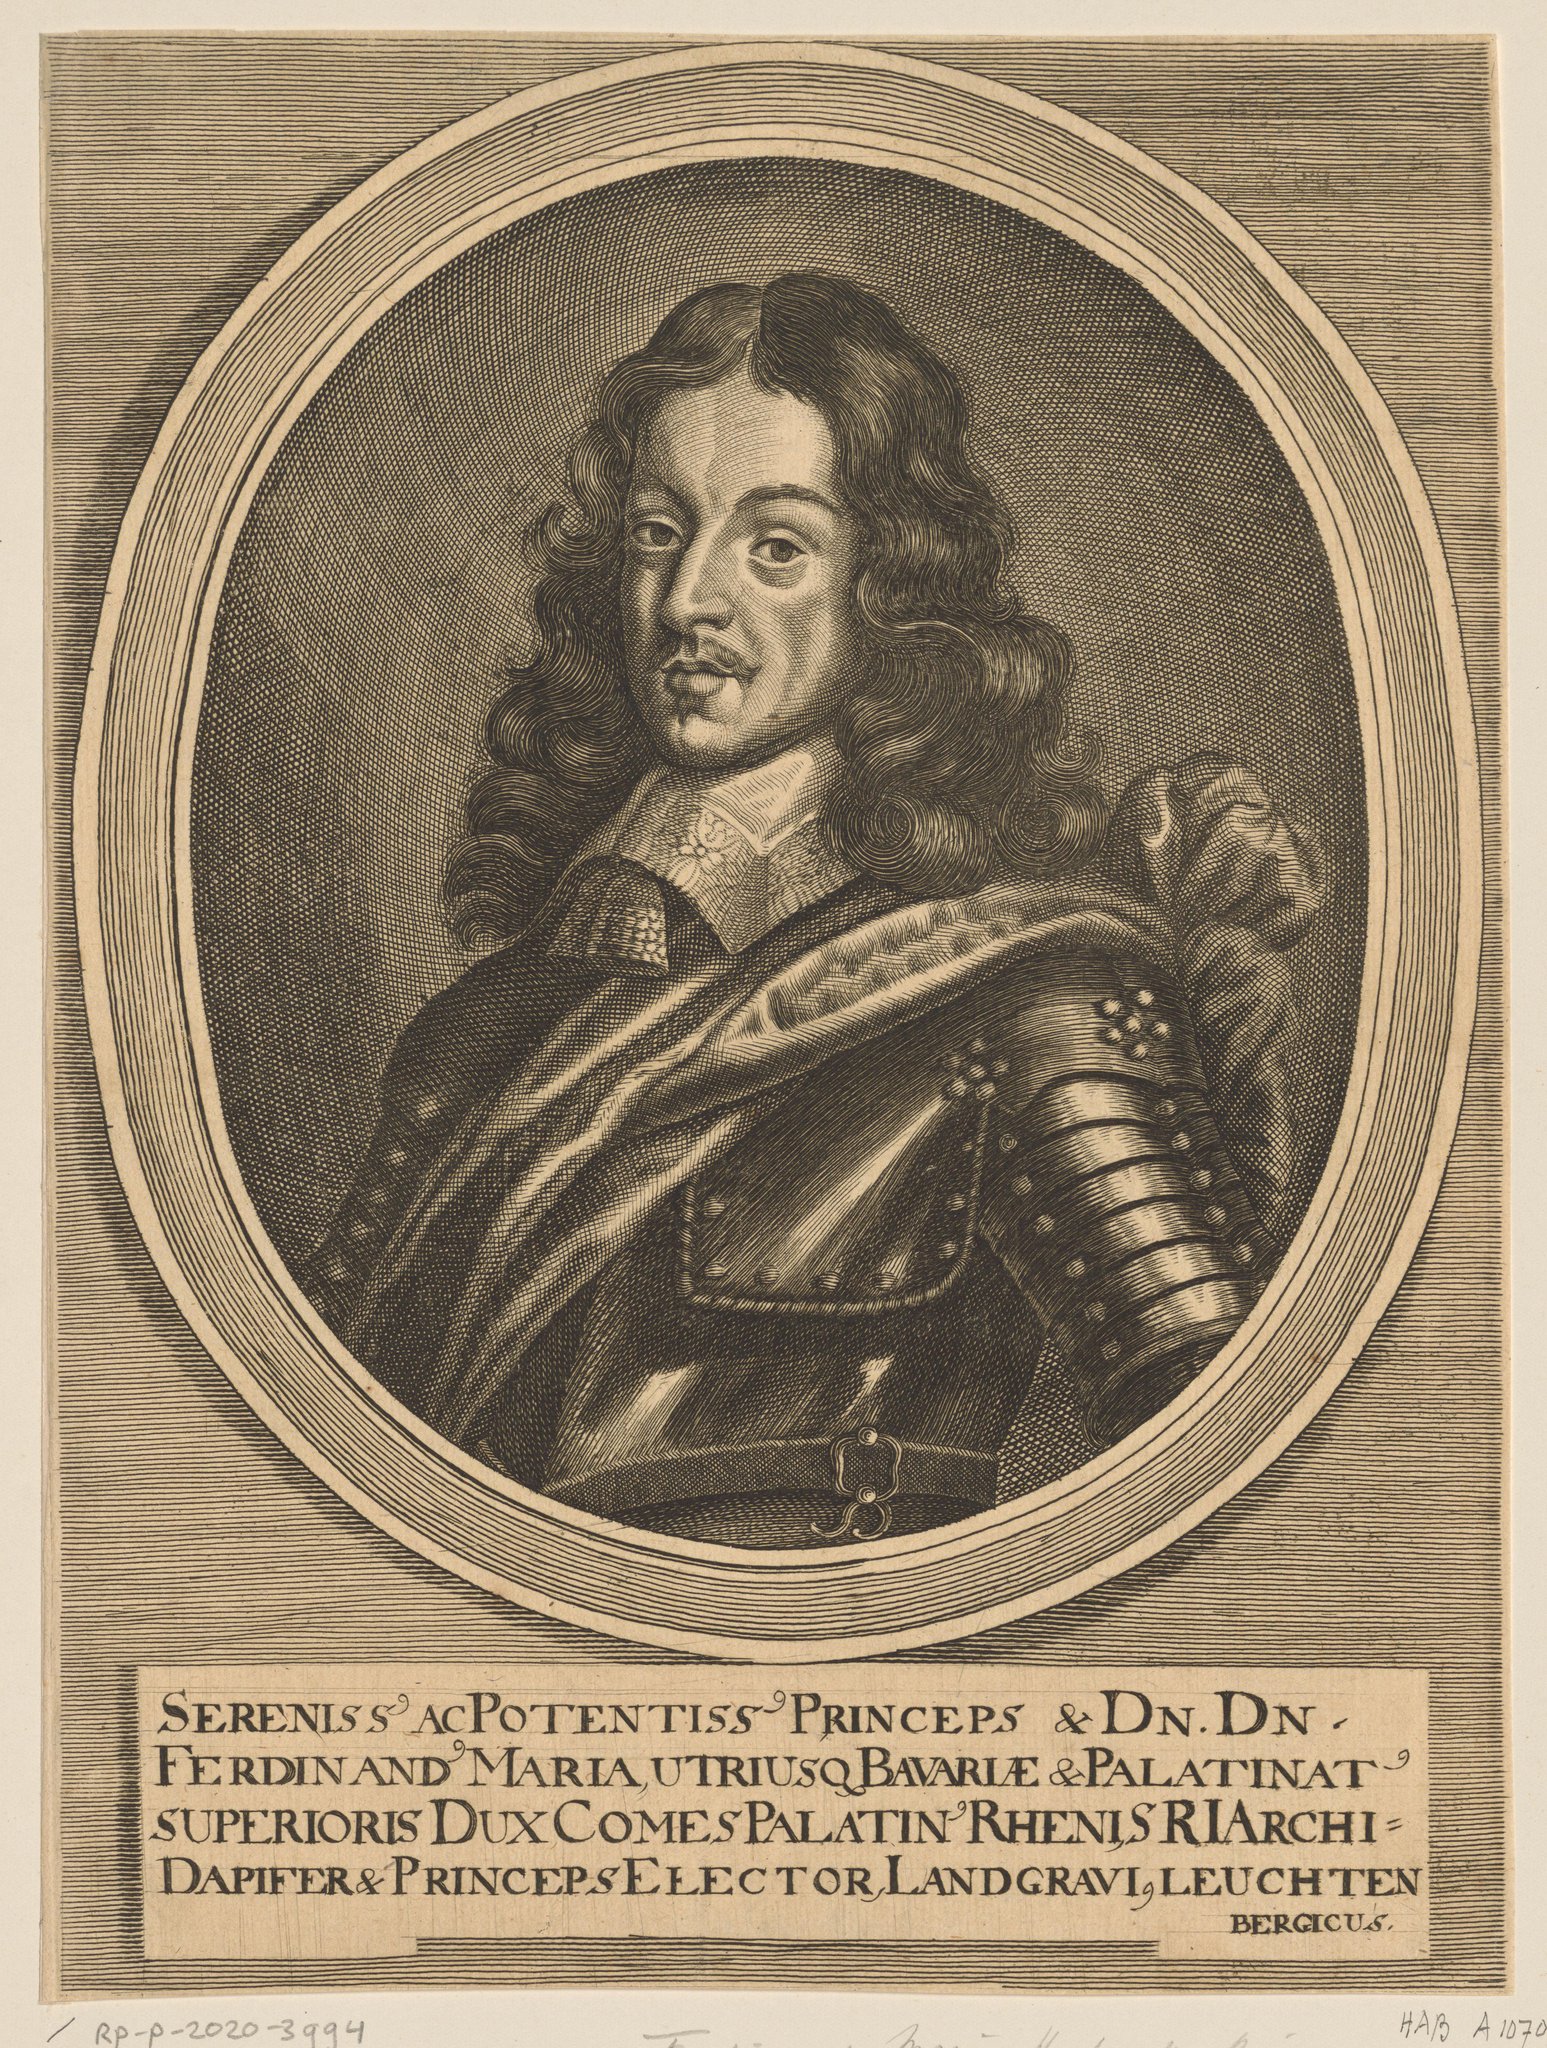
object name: print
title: Portret van Ferdinand Maria van Beieren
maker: Anonymous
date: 1655-1680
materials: paper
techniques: engraving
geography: germany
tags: ferdinand maria keurvorst van beieren, armour, historical persons